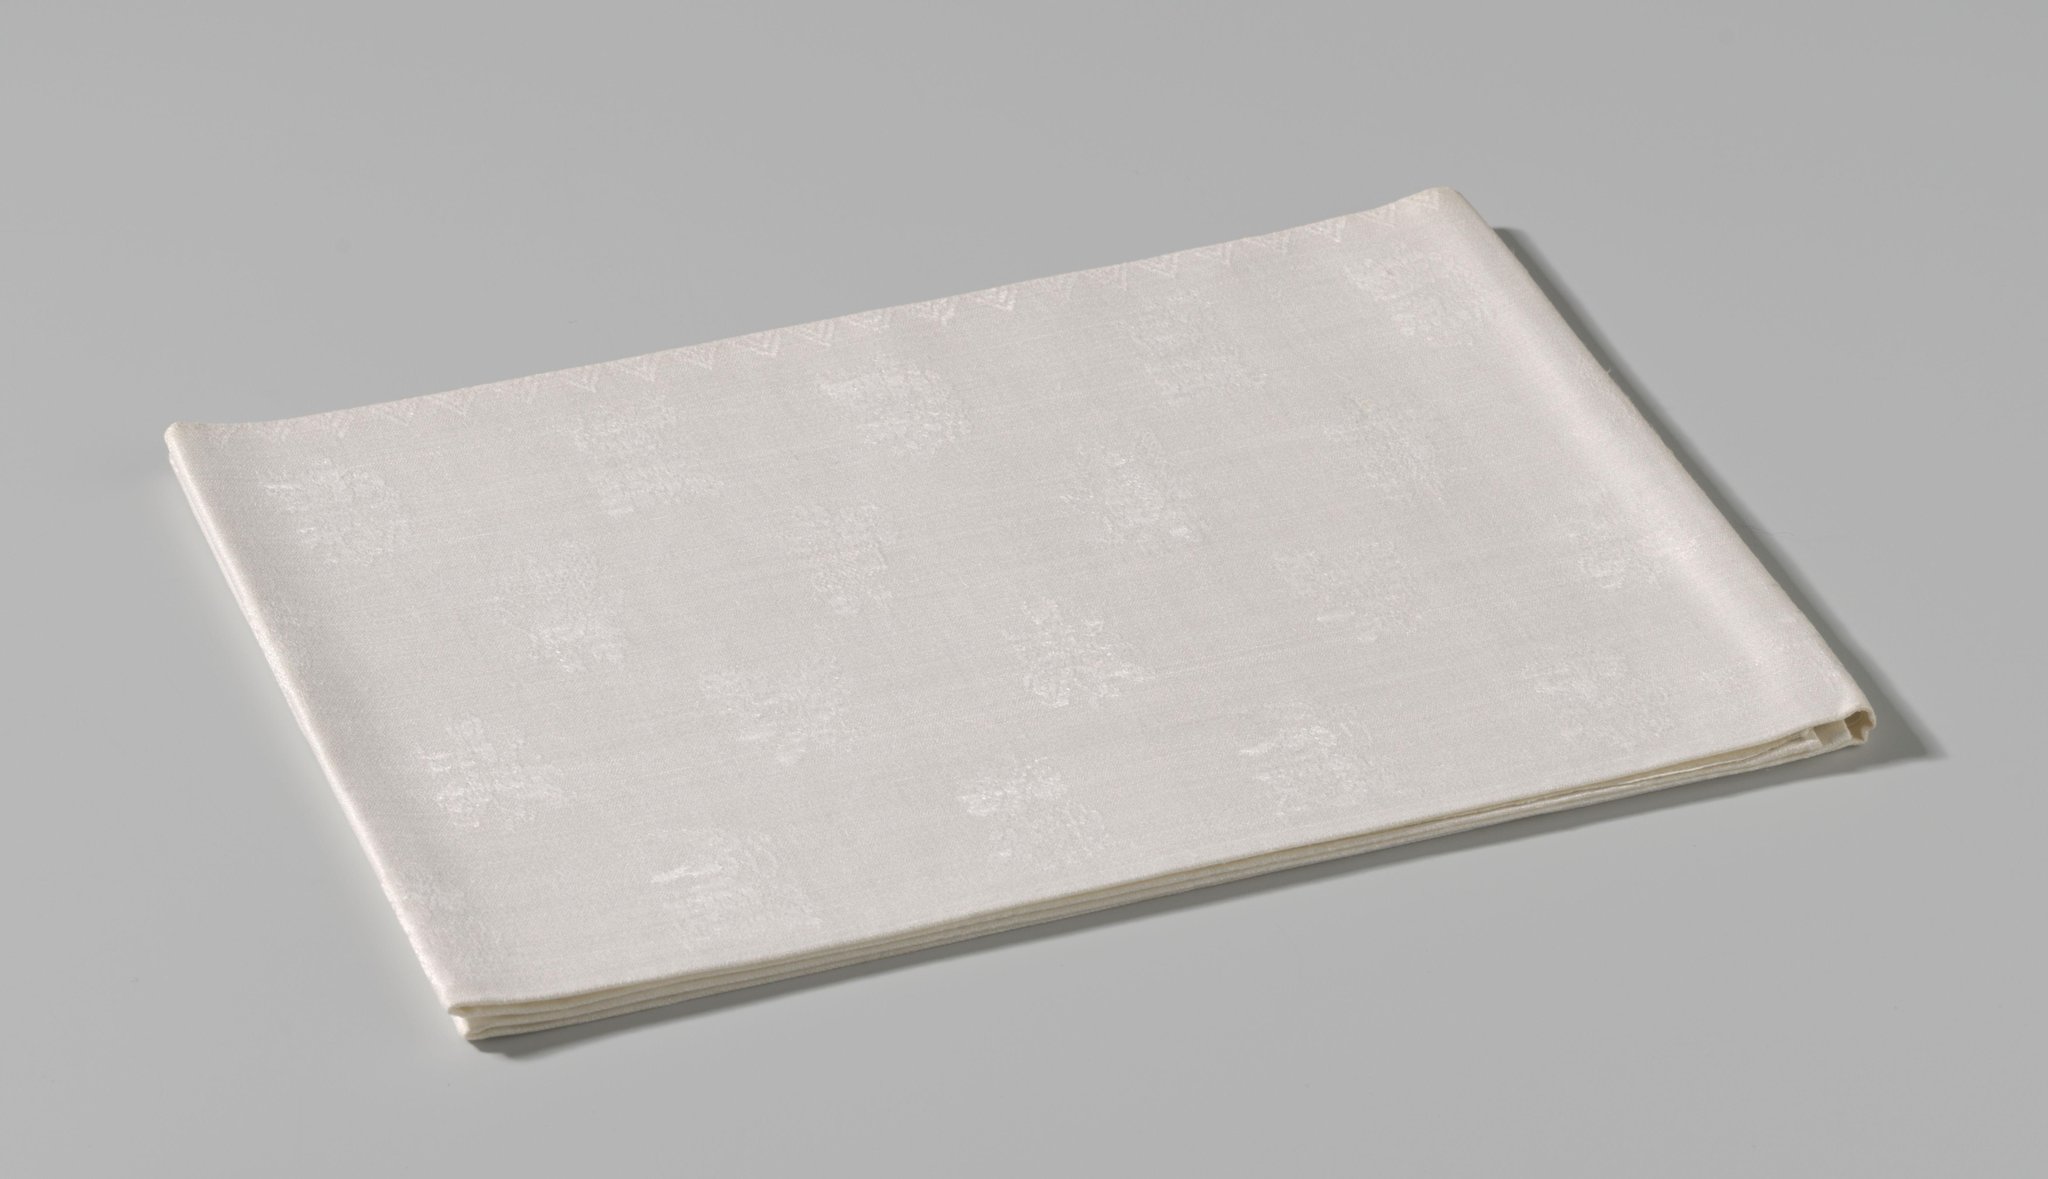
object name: napkin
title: Servet van linnendamast met een bloempatroon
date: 1800-1900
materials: linen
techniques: damask, weave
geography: netherlands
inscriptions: mark: ‘MC’, number: ‘24’